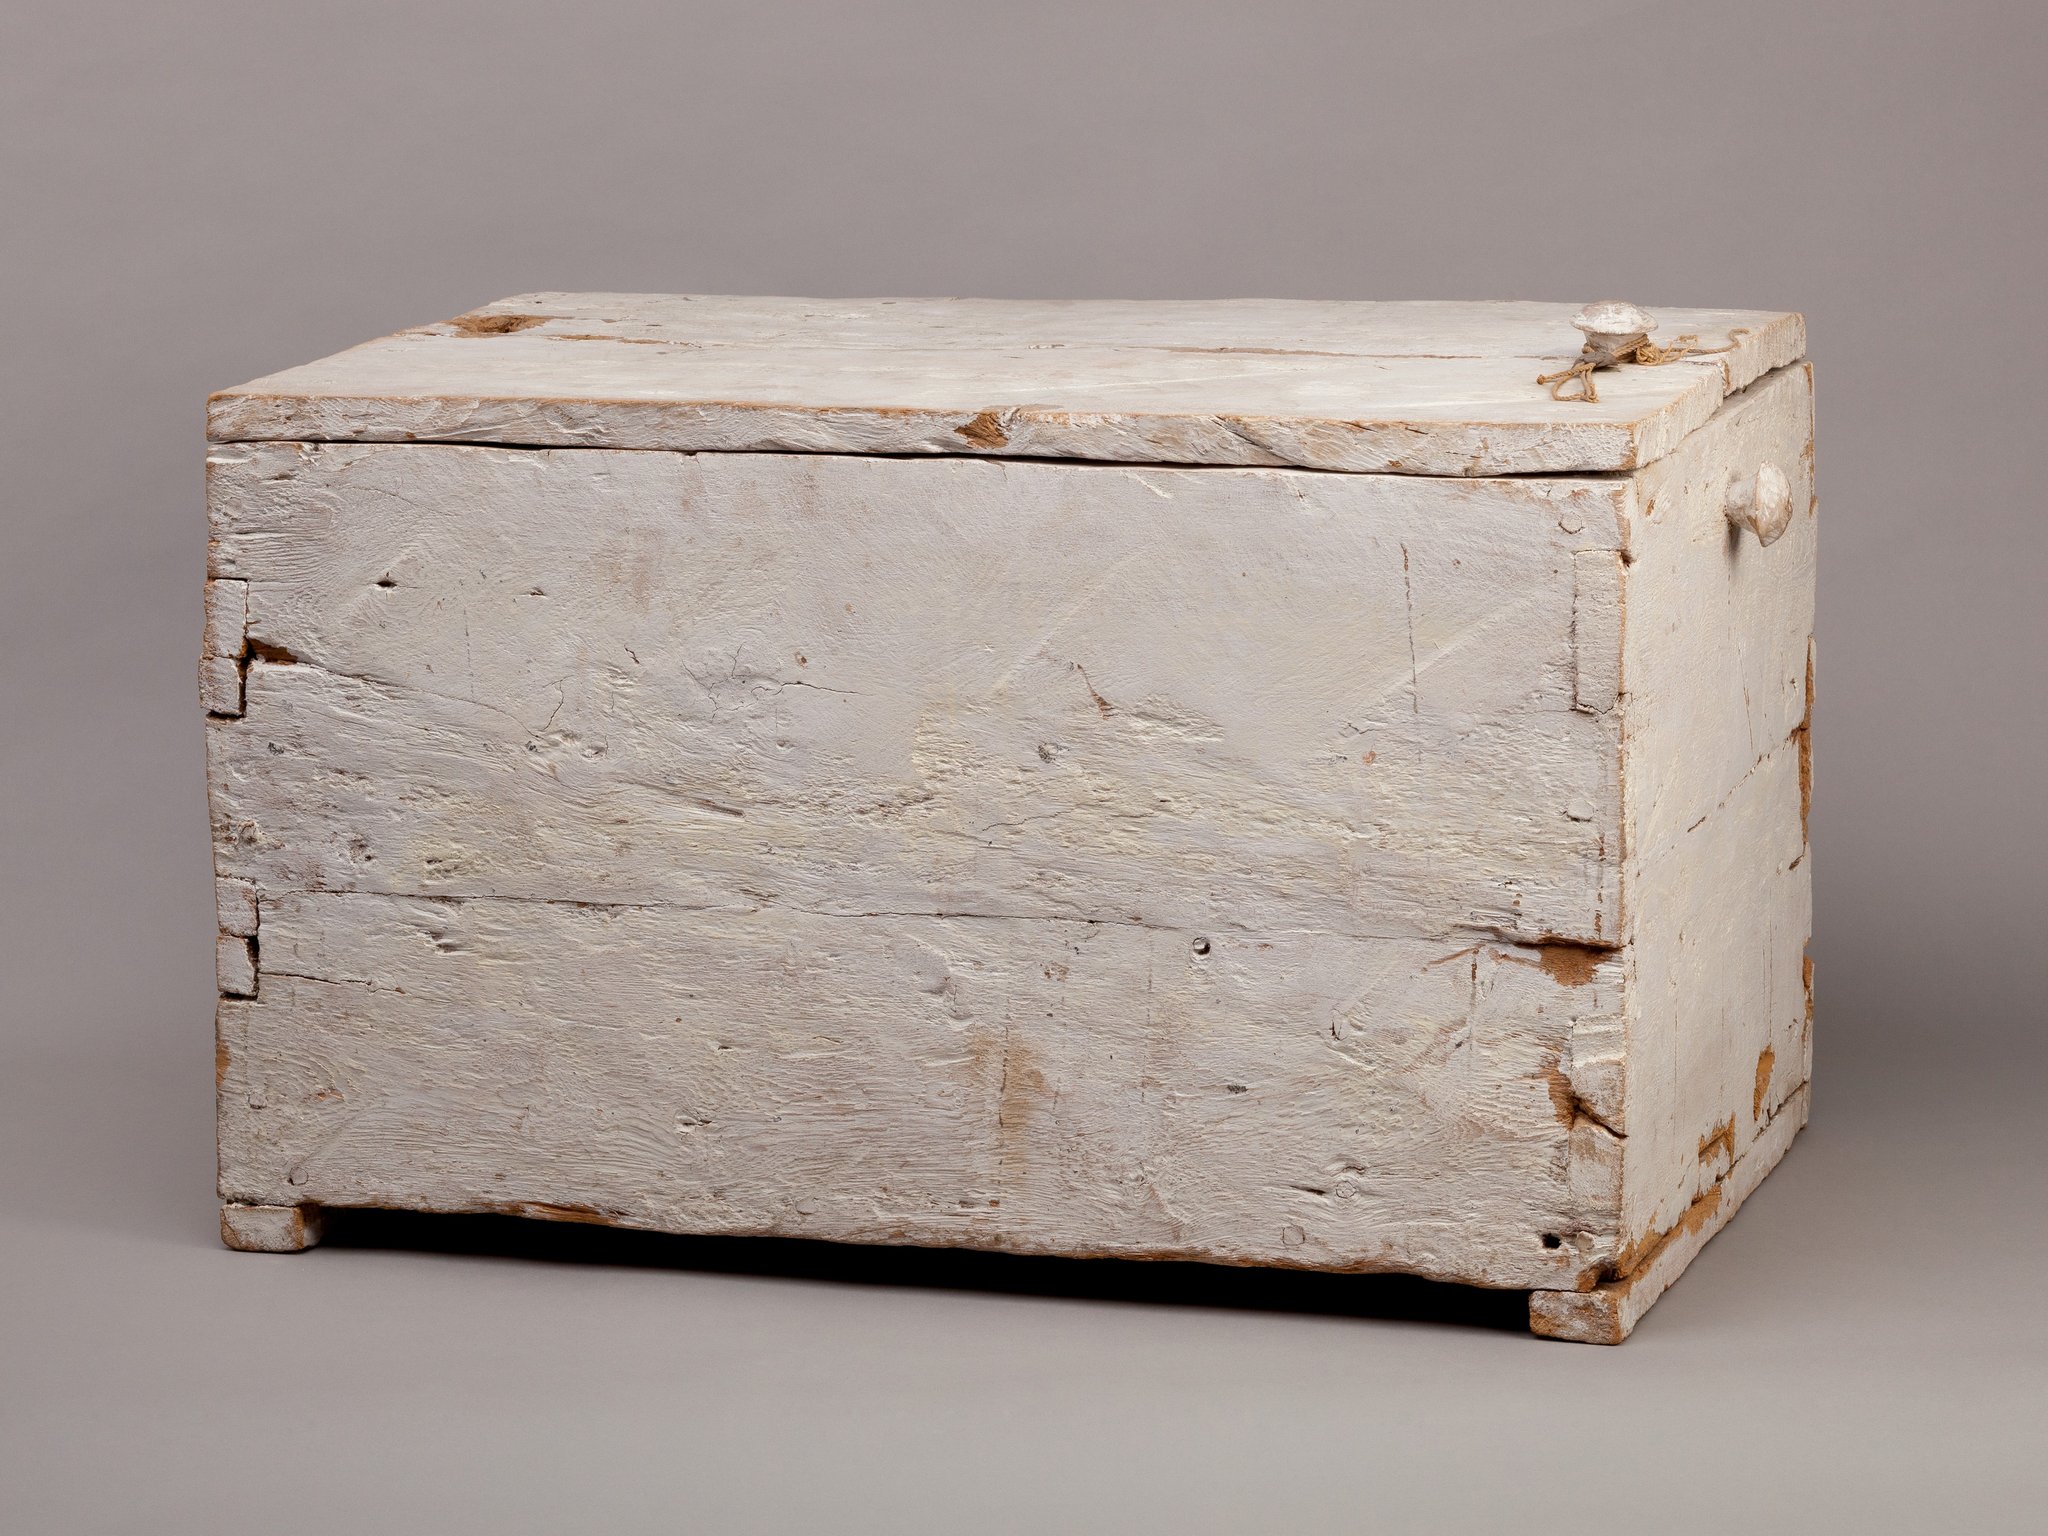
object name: box, flat lid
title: Rectangular Linen Chest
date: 1492-1473 BCE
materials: gesso, wood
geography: egypt